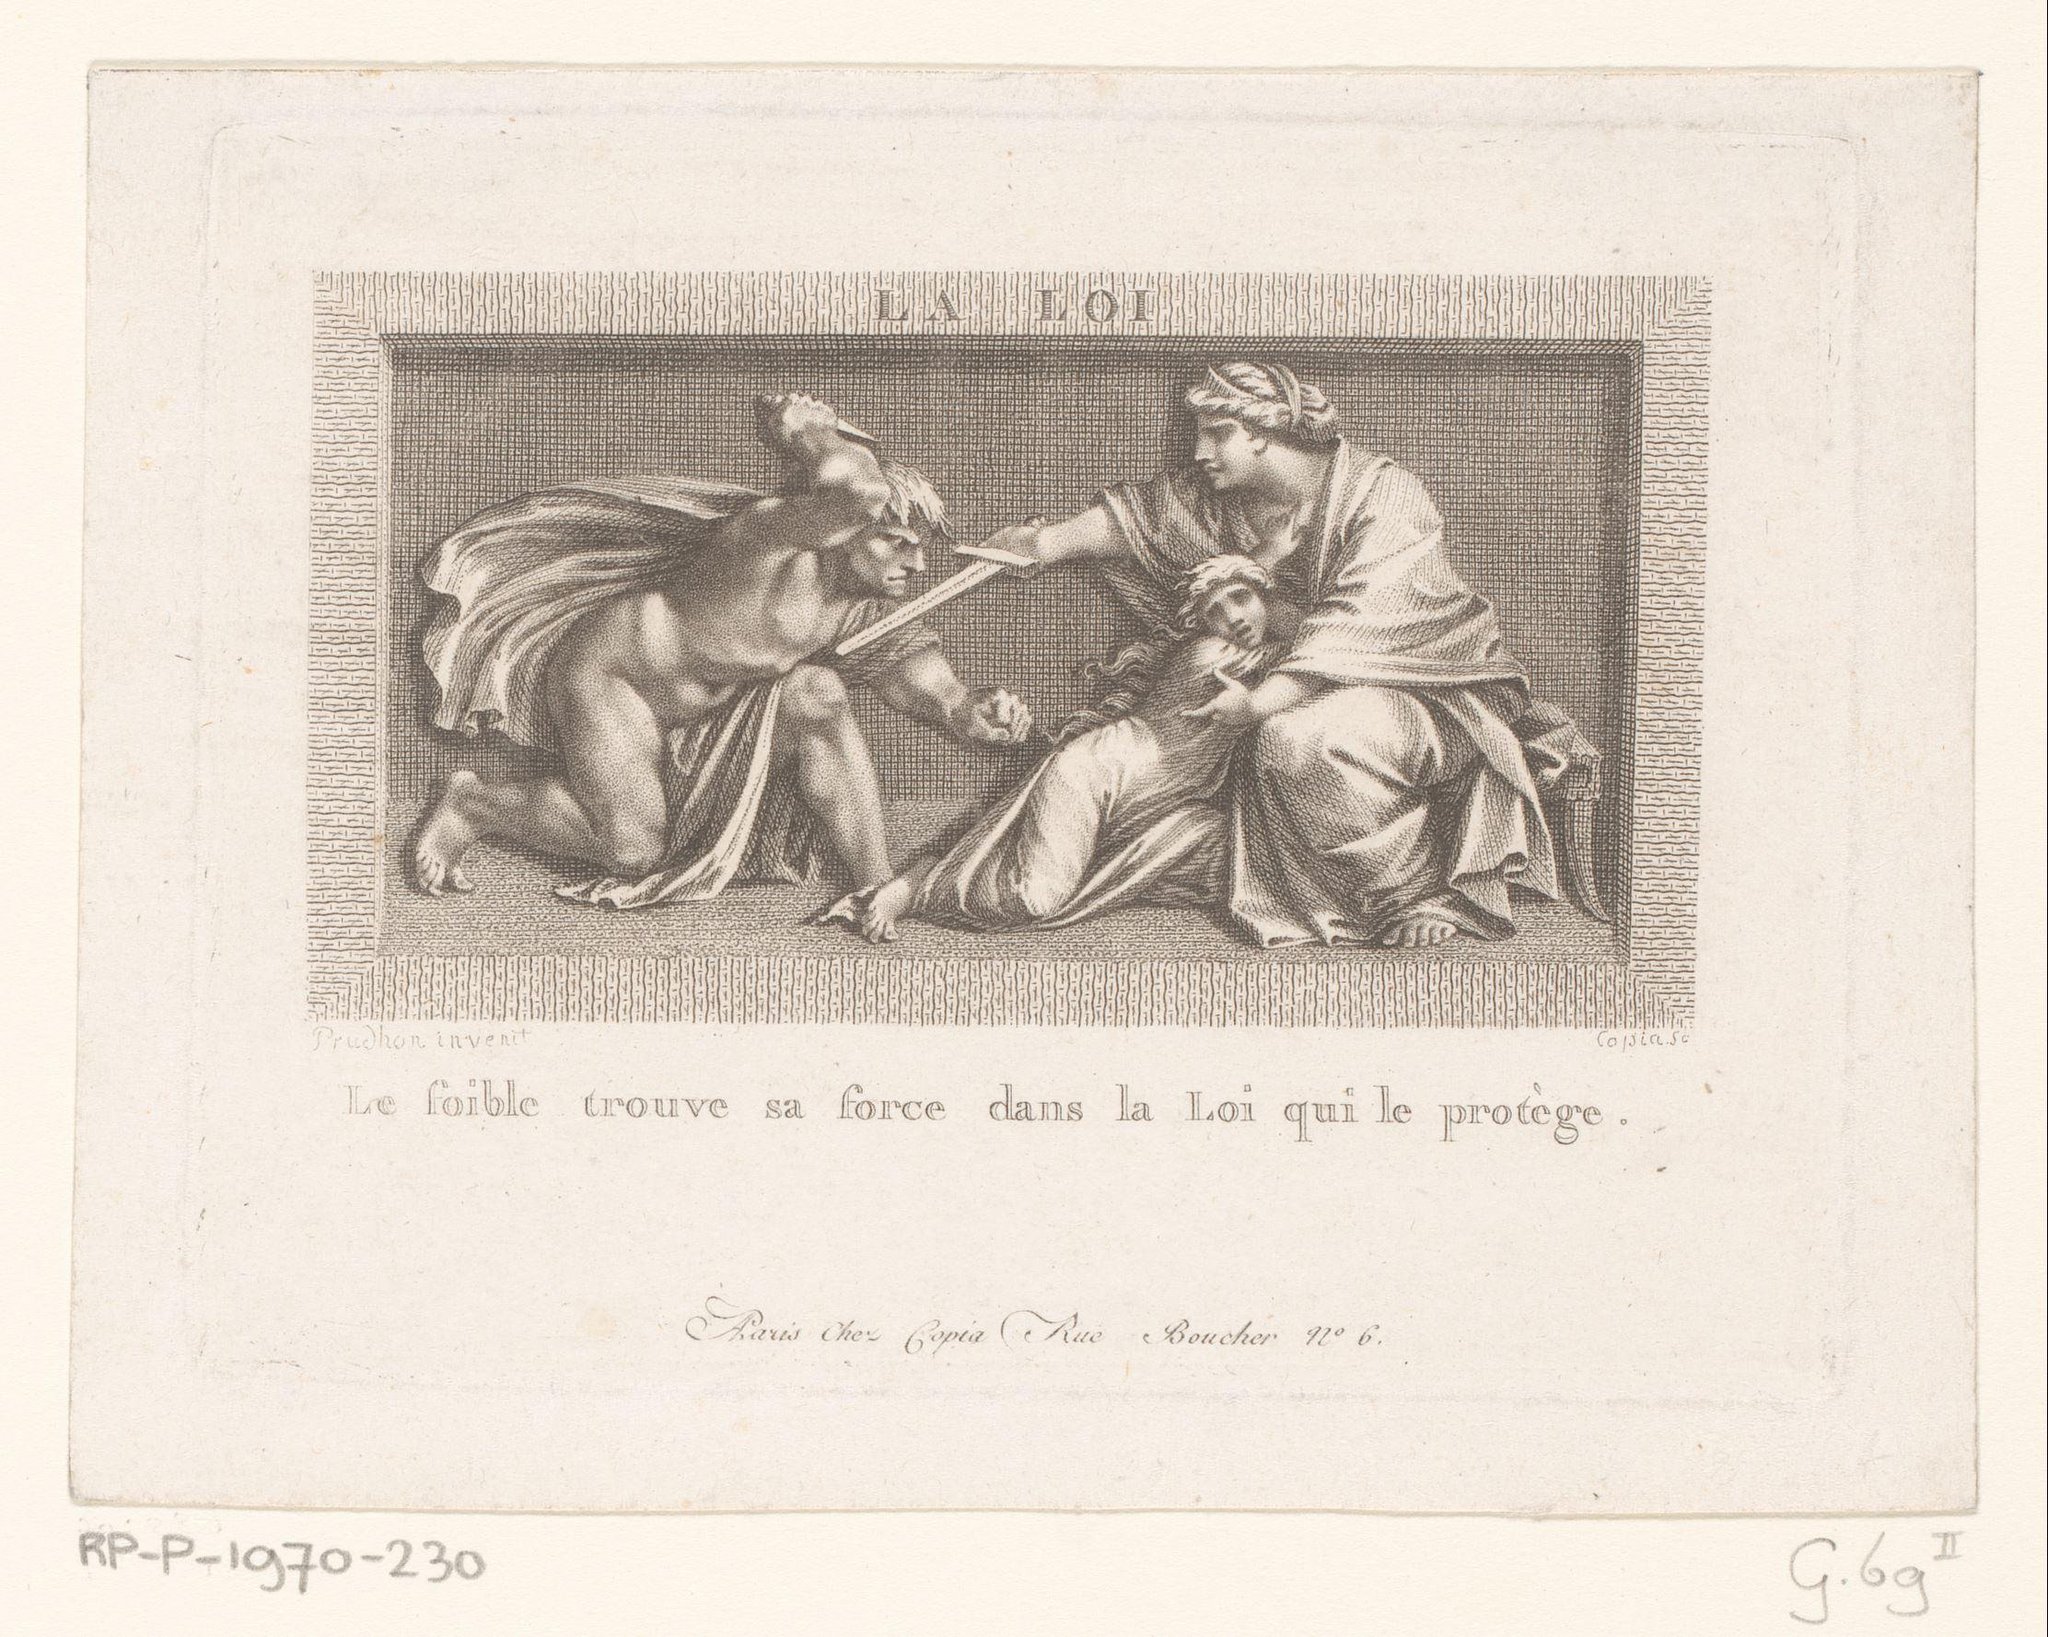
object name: print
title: La Loi/ Le foible trouve sa force dans la Loi qui le protège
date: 1789-1799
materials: paper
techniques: engraving, etching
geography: paris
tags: justitia (justice) as roman personification, justice; 'forza alla giustitia sottoposta', 'giustitia', 'giustitia retta', 'giustitia rigorosa', 'impietà e violenza soggetta alla giustitia' (ripa), innocence; 'innocenza', 'innocenza o purità' (ripa)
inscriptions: collector's mark: Lugt 2228, collector's mark: Lugt 2760